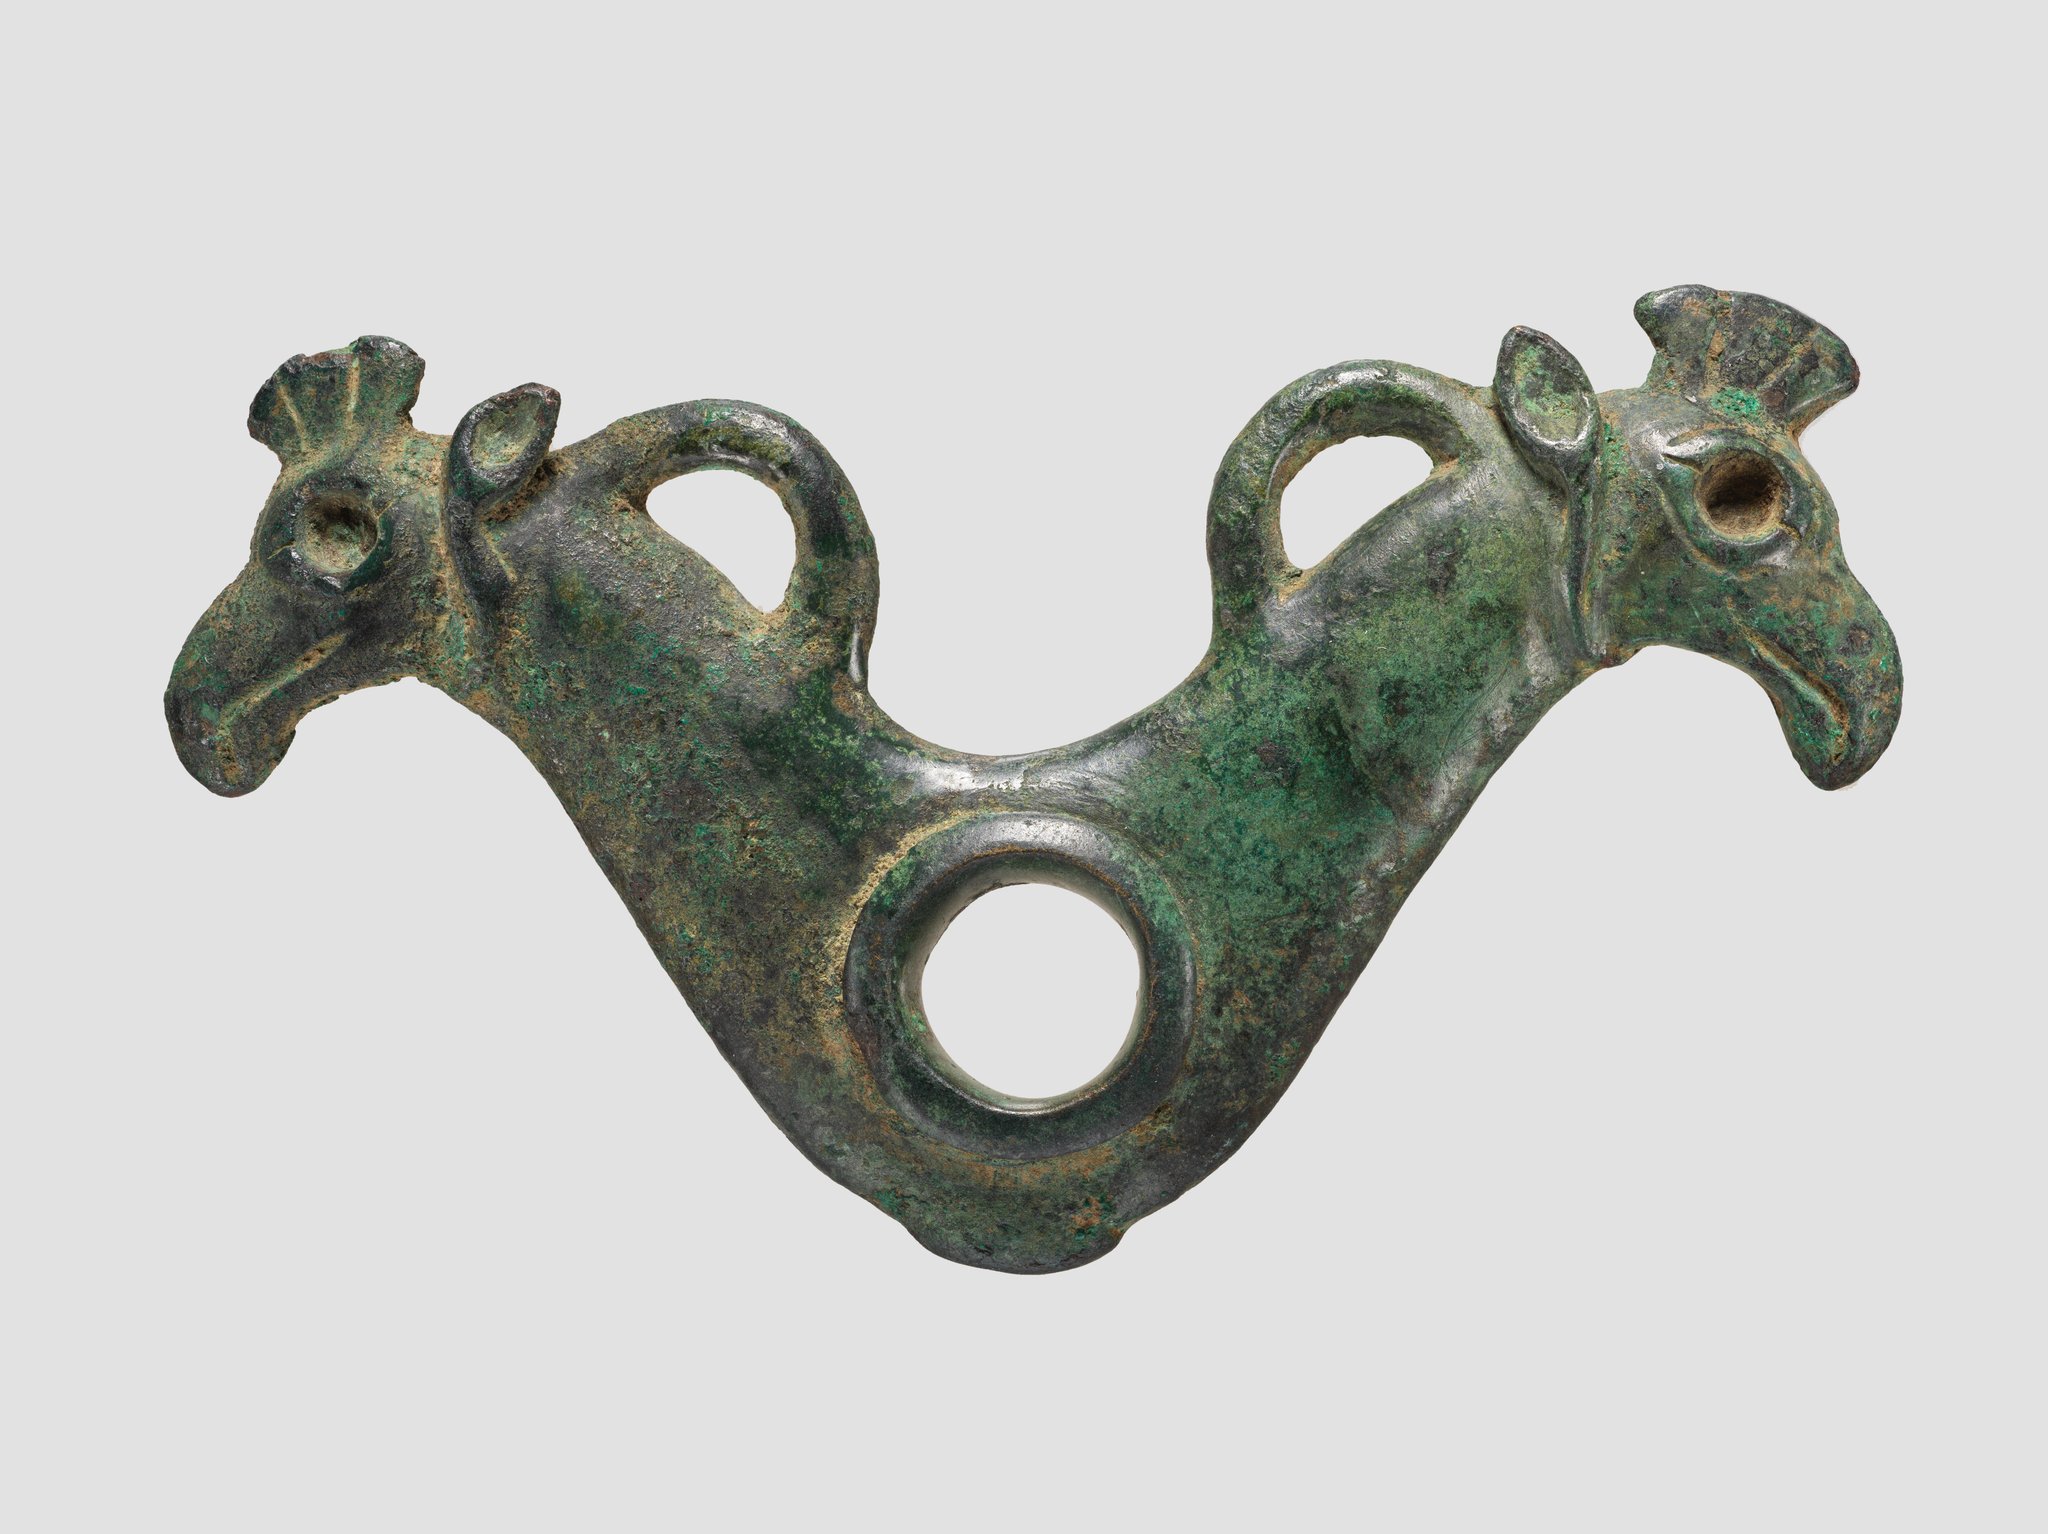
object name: horse bit cheekpiece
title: Horse bit cheekpiece in form of addorsed griffin heads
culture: iranian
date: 800-601 BCE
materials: bronze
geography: iran, probably from luristan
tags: griffins